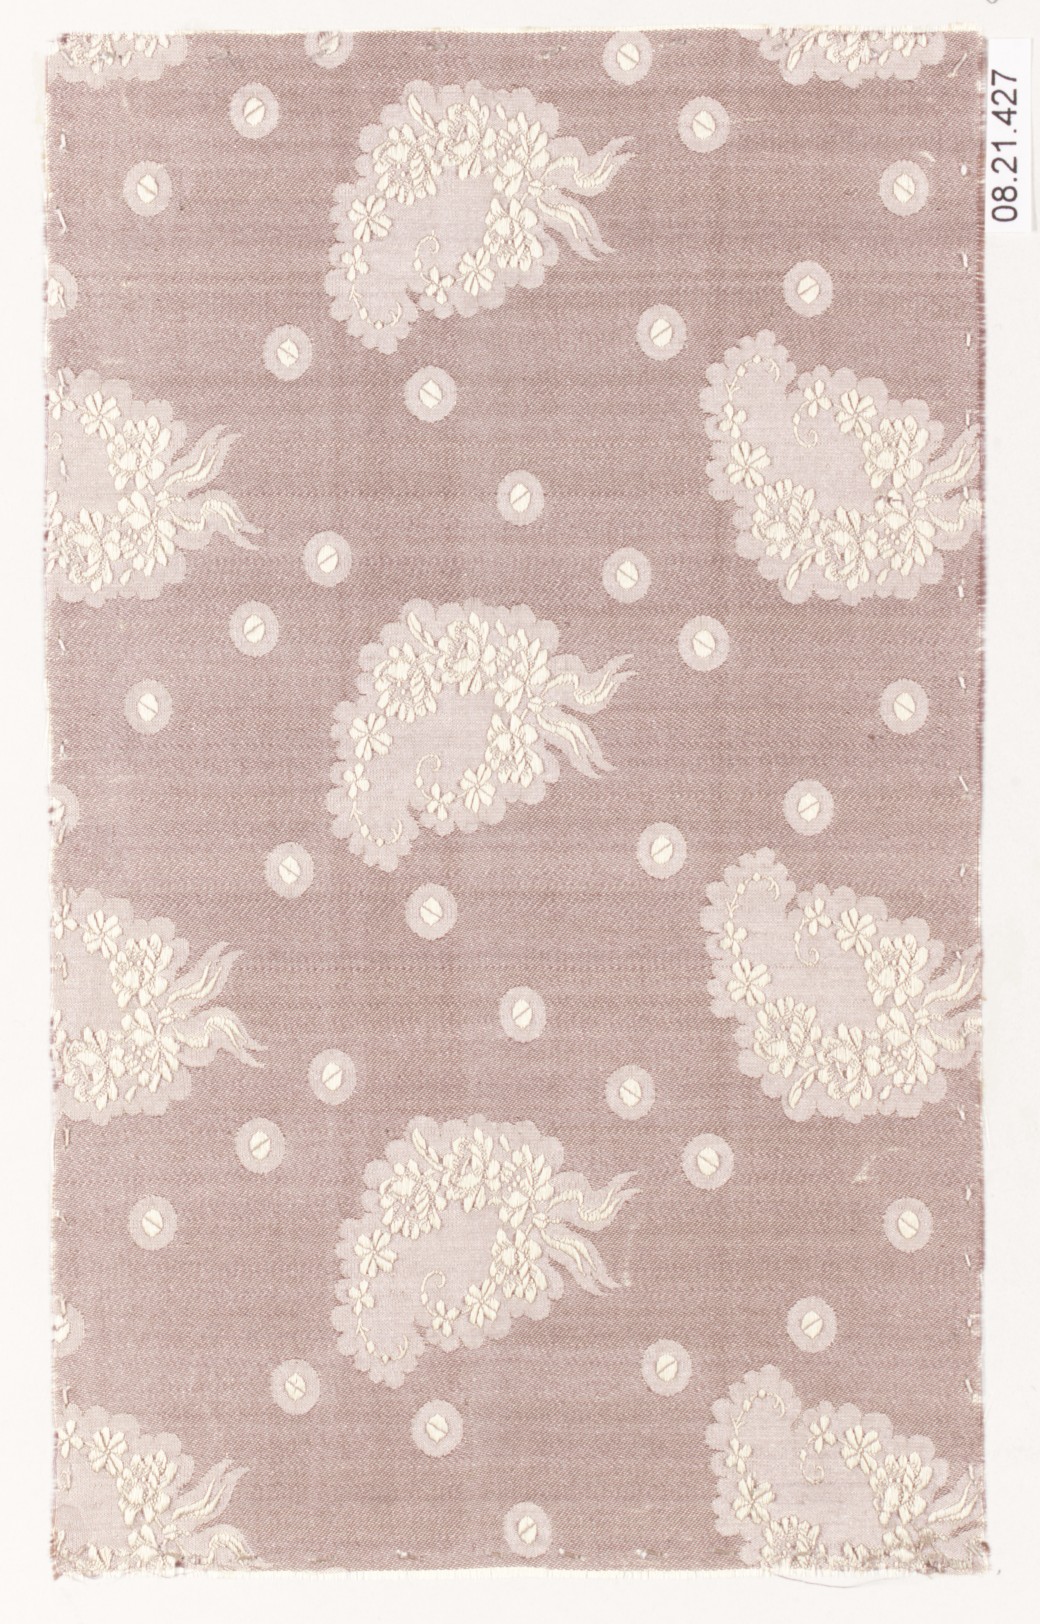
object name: textile sample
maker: Anonymous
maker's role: designer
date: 1900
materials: silk